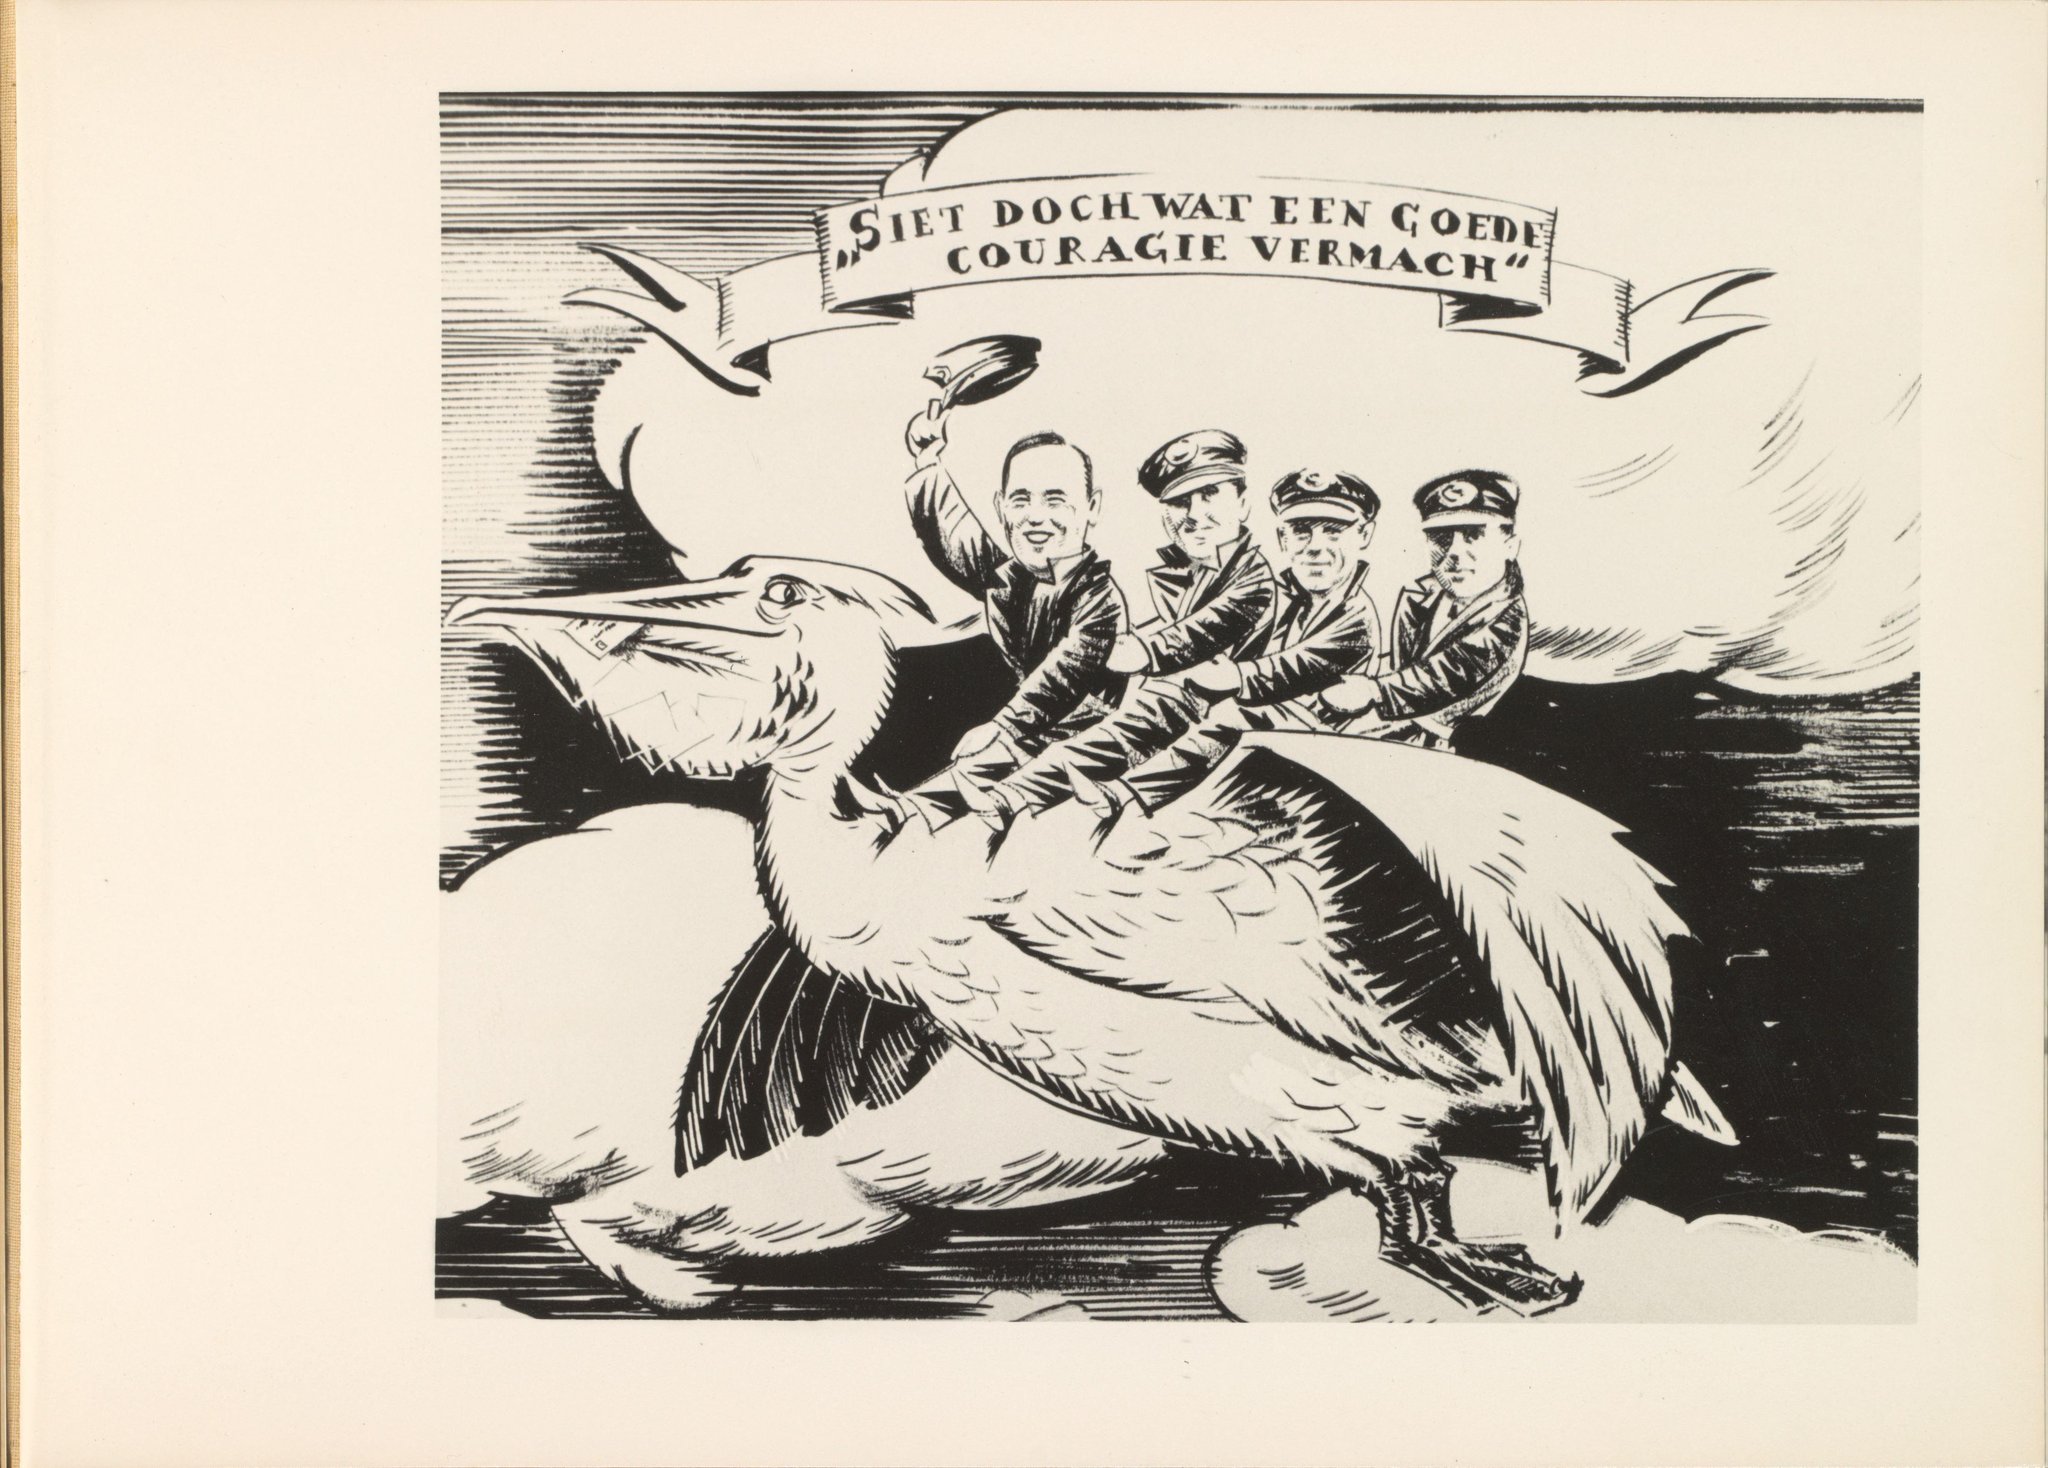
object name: photograph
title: Cartoon van de bemanning van de 'Pelikaan'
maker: Anonymous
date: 1933-1949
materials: cardboard, paper, photographic support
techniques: gelatin silver print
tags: airborne traffic, aviation, pilot, flight crew, travelling; tourism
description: Albumblad met een fotoreproductie van een cartoon van de vier bemanningsleden van de 'Pelikaan', het KLM-toestel dat in december 1933 in een recordtijd van vier dagen Kerst- en nieuwjaarspost van Amsterdam naar Batavia bracht. Bovenaan de spreuk 'Siet doch wat een goede courage vermach'. Onderdeel van Herdenkingsalbum van de Indië-lijn van de KLM, deel I.